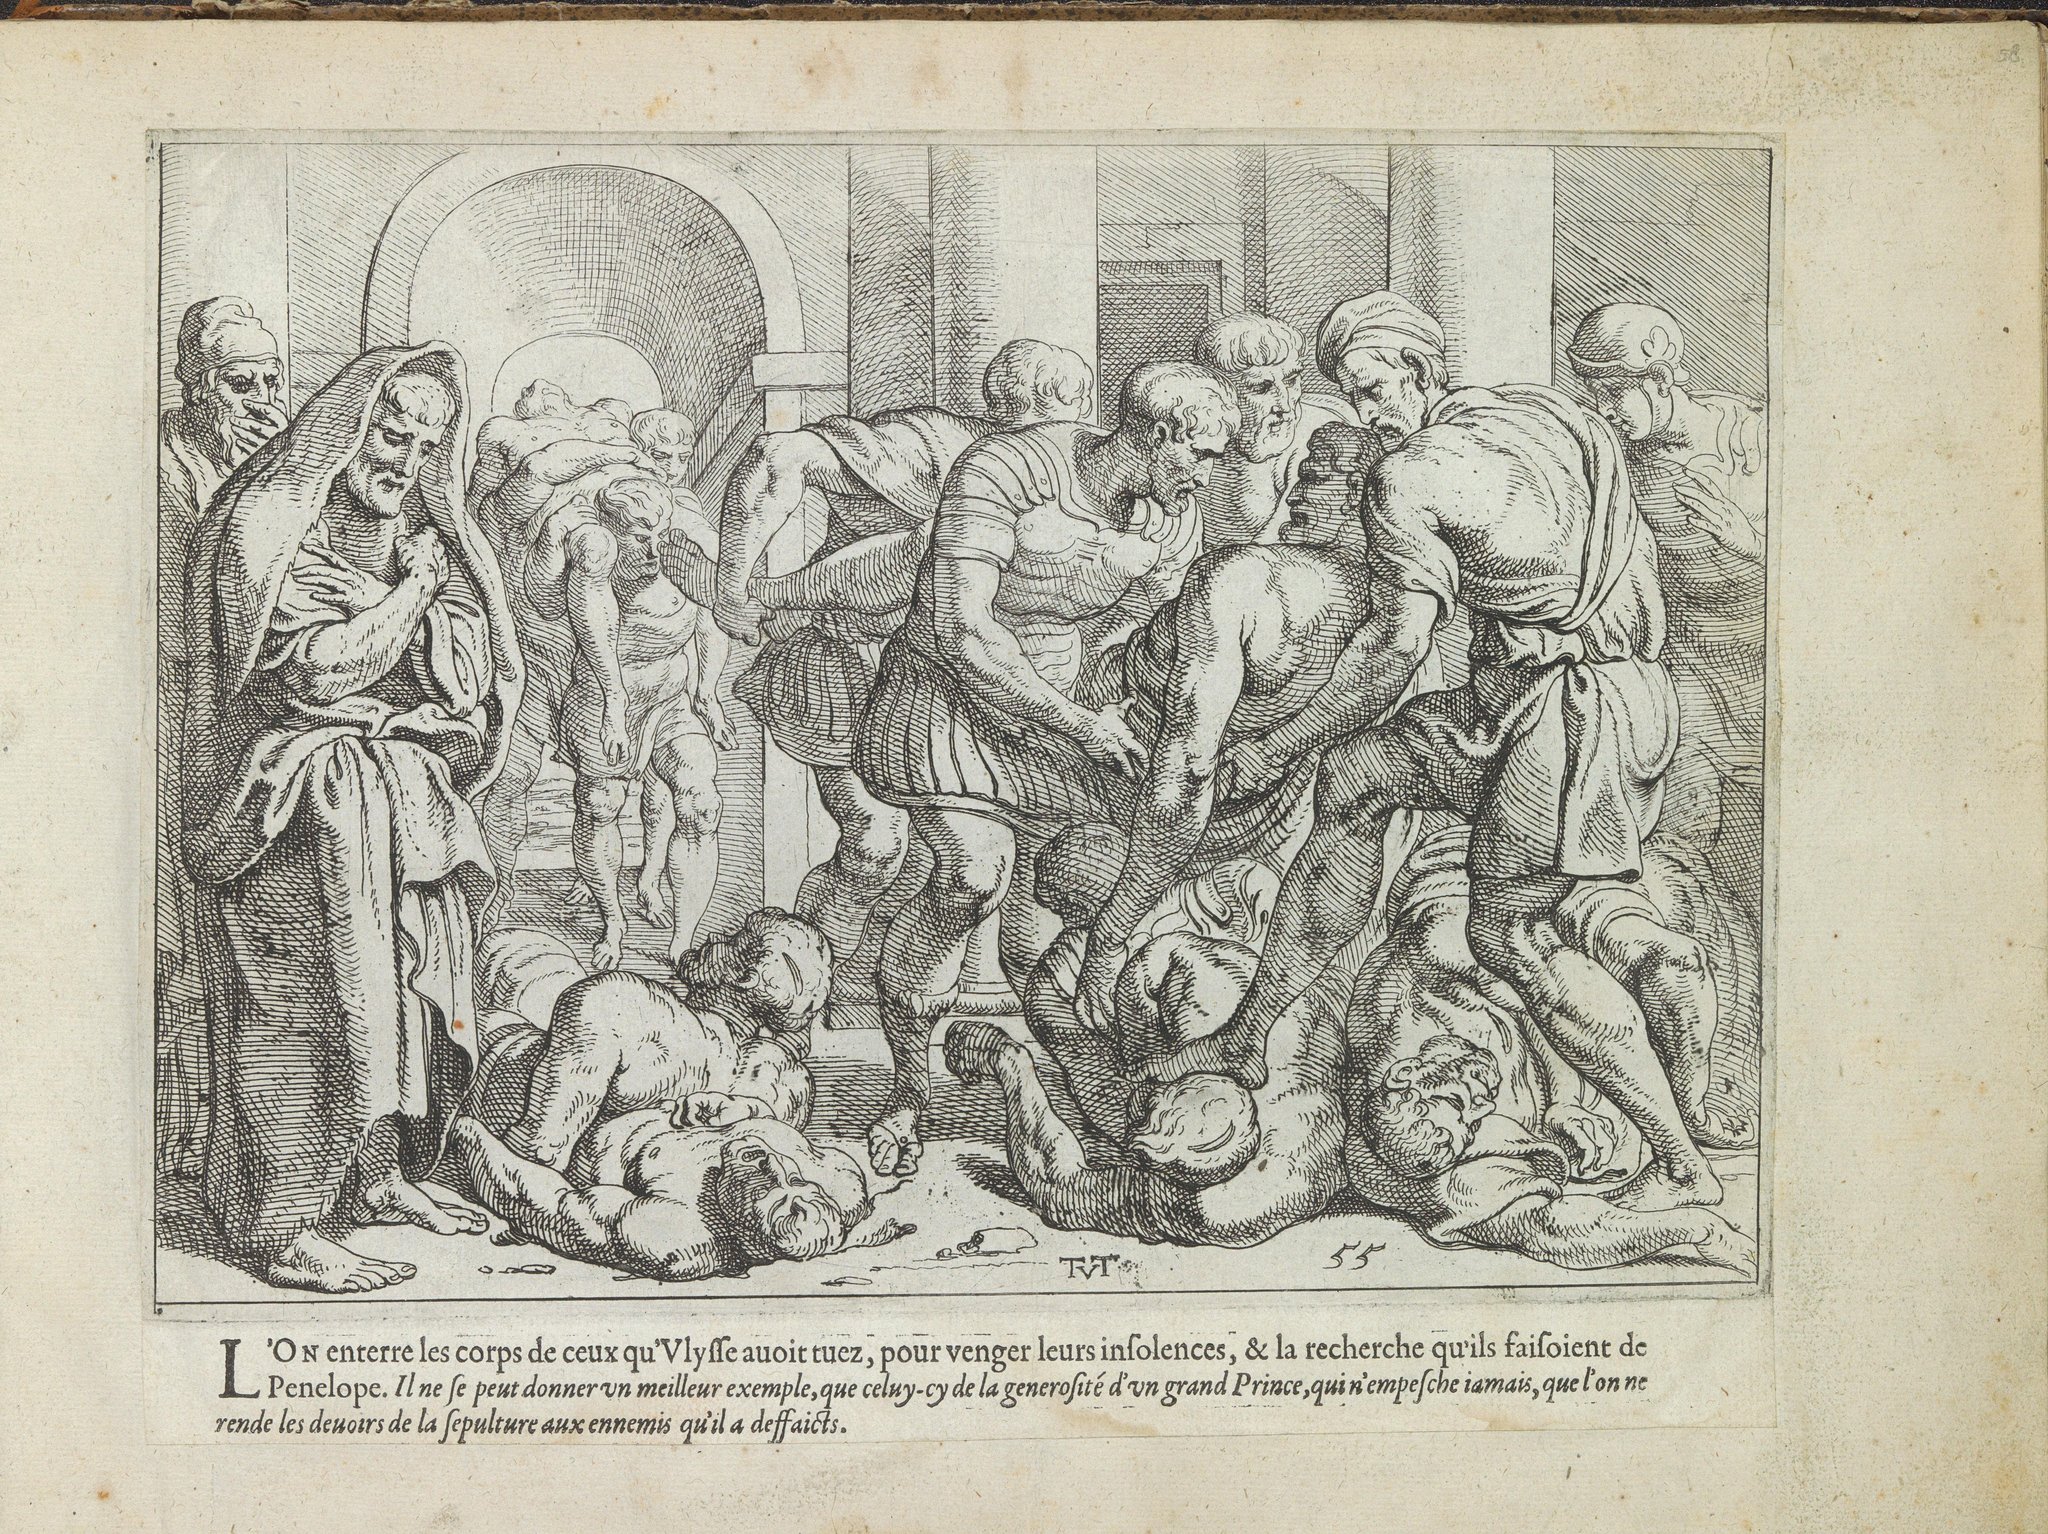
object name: print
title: Les Travaux d'Ulysse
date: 1633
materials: paper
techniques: engraving, etching, letterpress printing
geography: paris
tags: sequel to the death of the suitors (homer, odyssey xxiv)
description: De familieleden van de door Odysseus gedode vrijers tillen de lijken weg om ze te begraven. De prent maakt deel uit van een album.